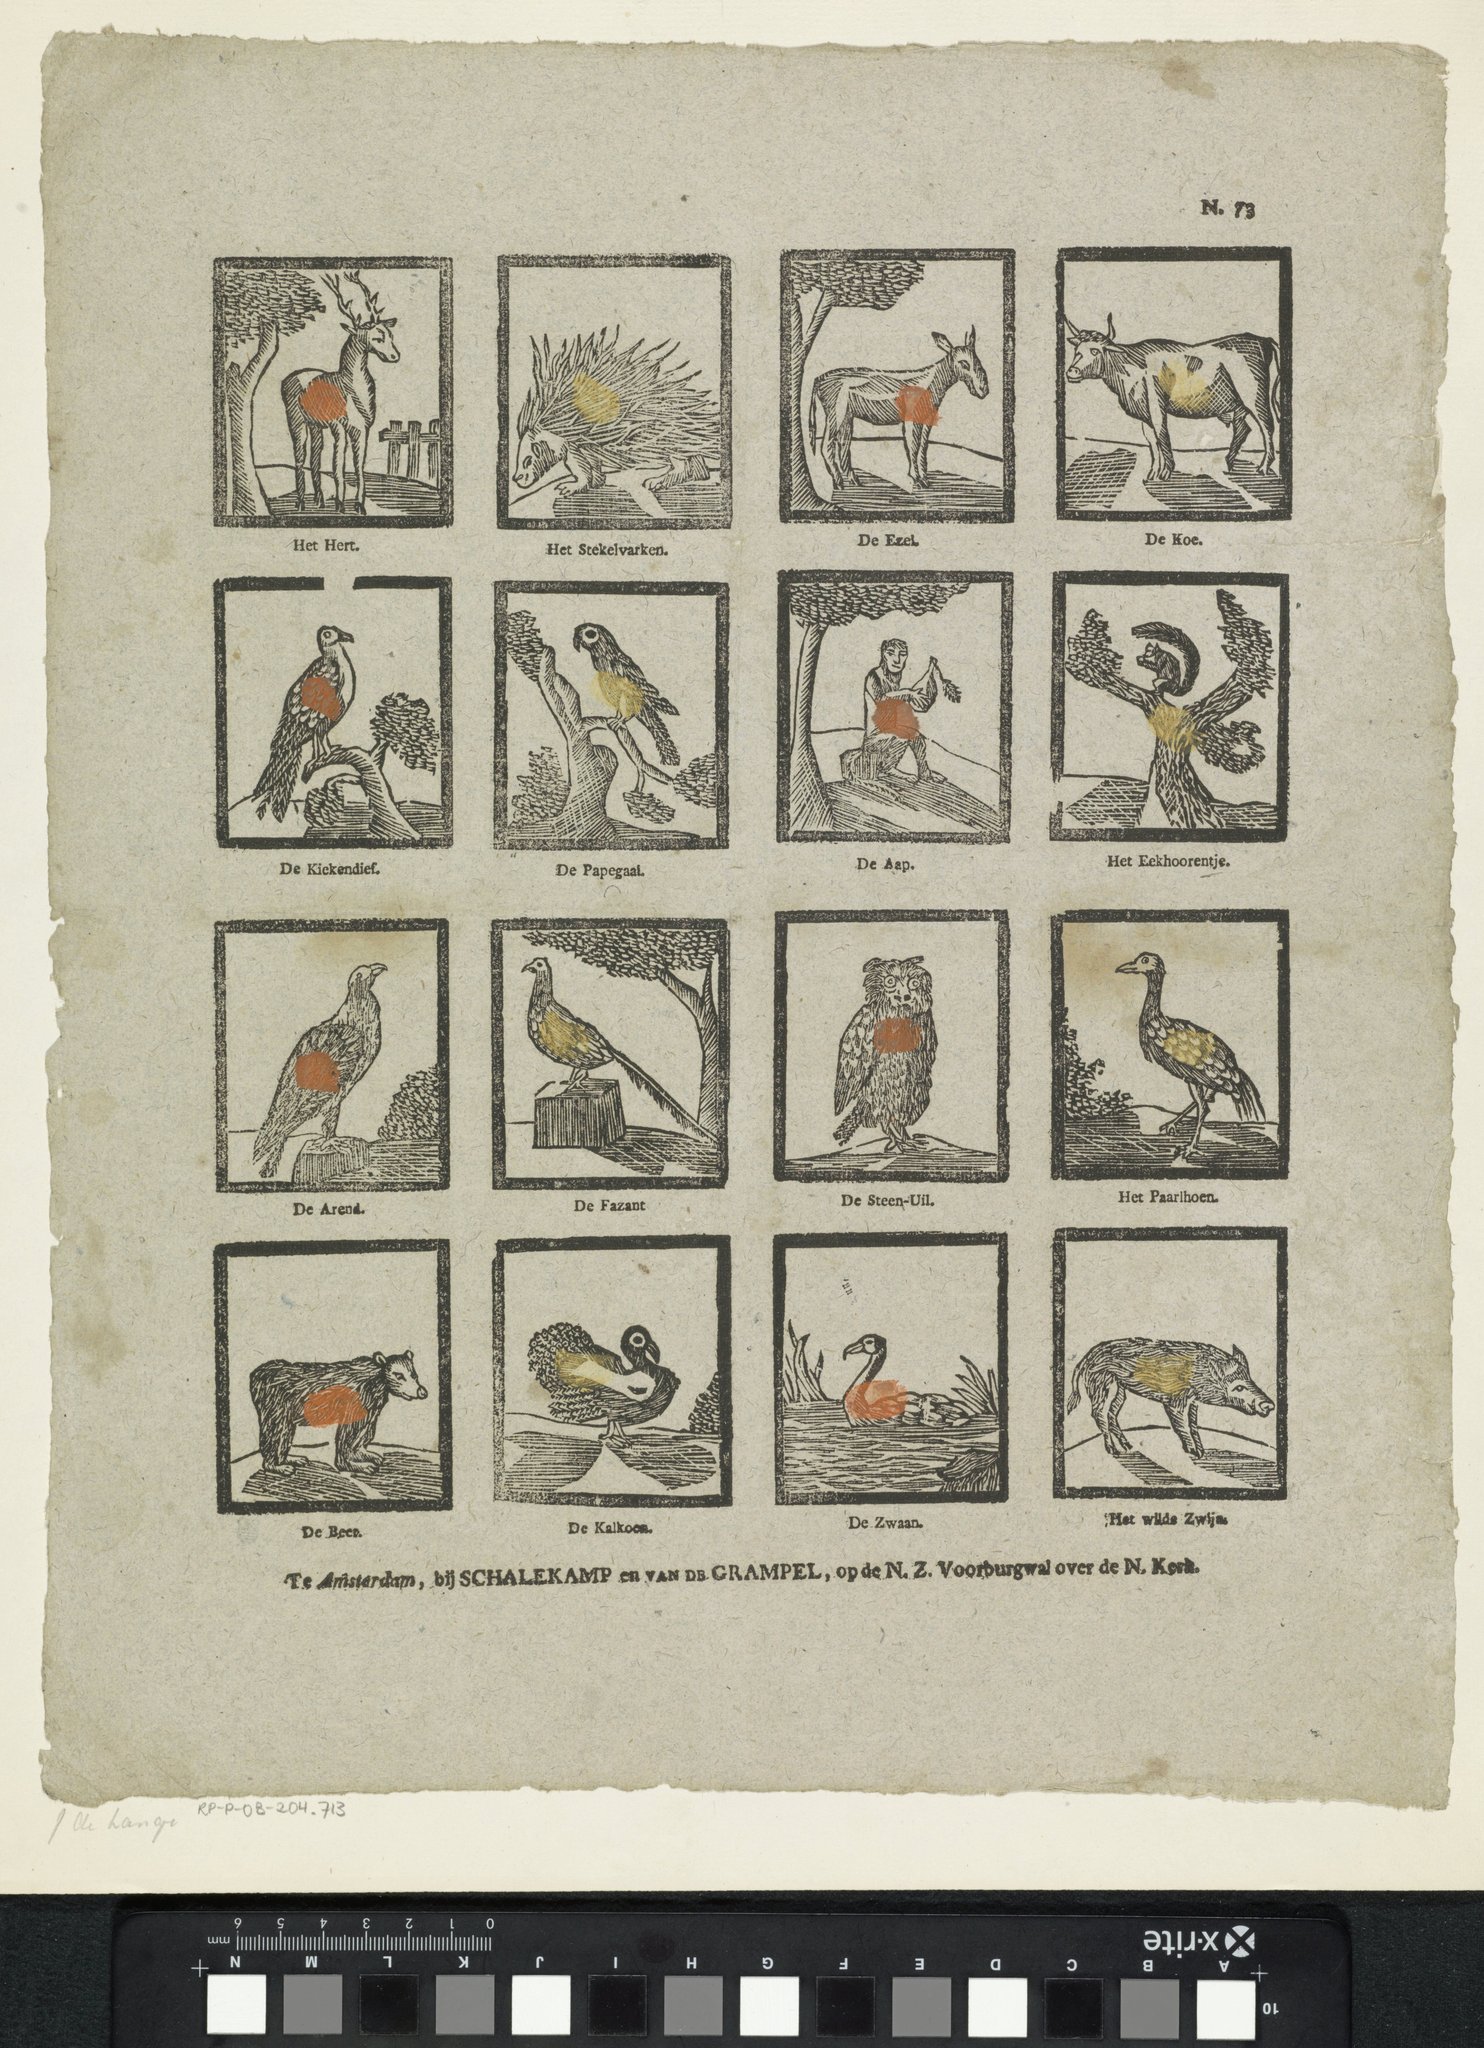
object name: popular print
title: Dieren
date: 1822-1849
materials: paper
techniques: colour, letterpress printing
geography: netherlands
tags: cow, hoofed animals: deer, animals, ass, donkey, birds, other mammals: porcupine, beasts of prey, predatory animals: bear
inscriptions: collector's mark: Lugt 2760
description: Blad met 16 voorstellingen van dieren, zoals een hert, een stekelvarken, een ezel en een koe. Onder elke afbeelding een onderschrift. Genummerd rechtsboven: N. 73.